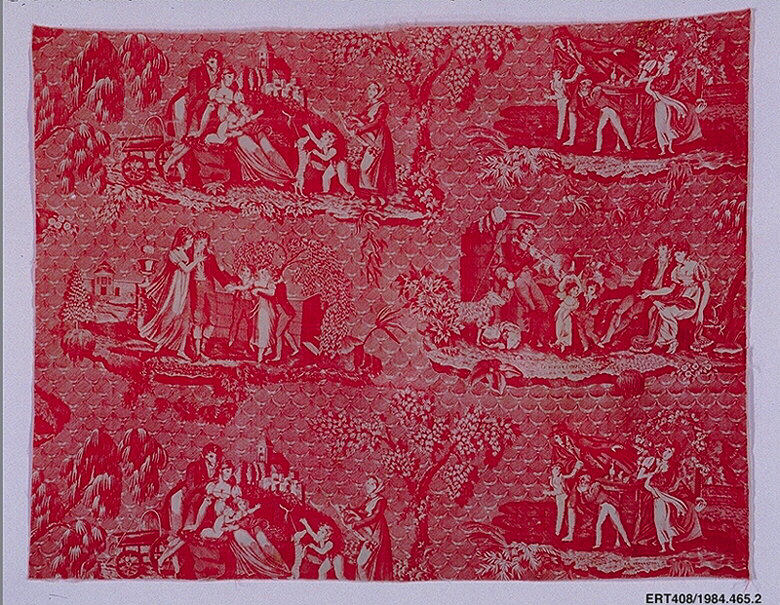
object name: piece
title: La Petite Savoyarde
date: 1801-1825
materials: cotton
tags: animals,boys,men,women,trees